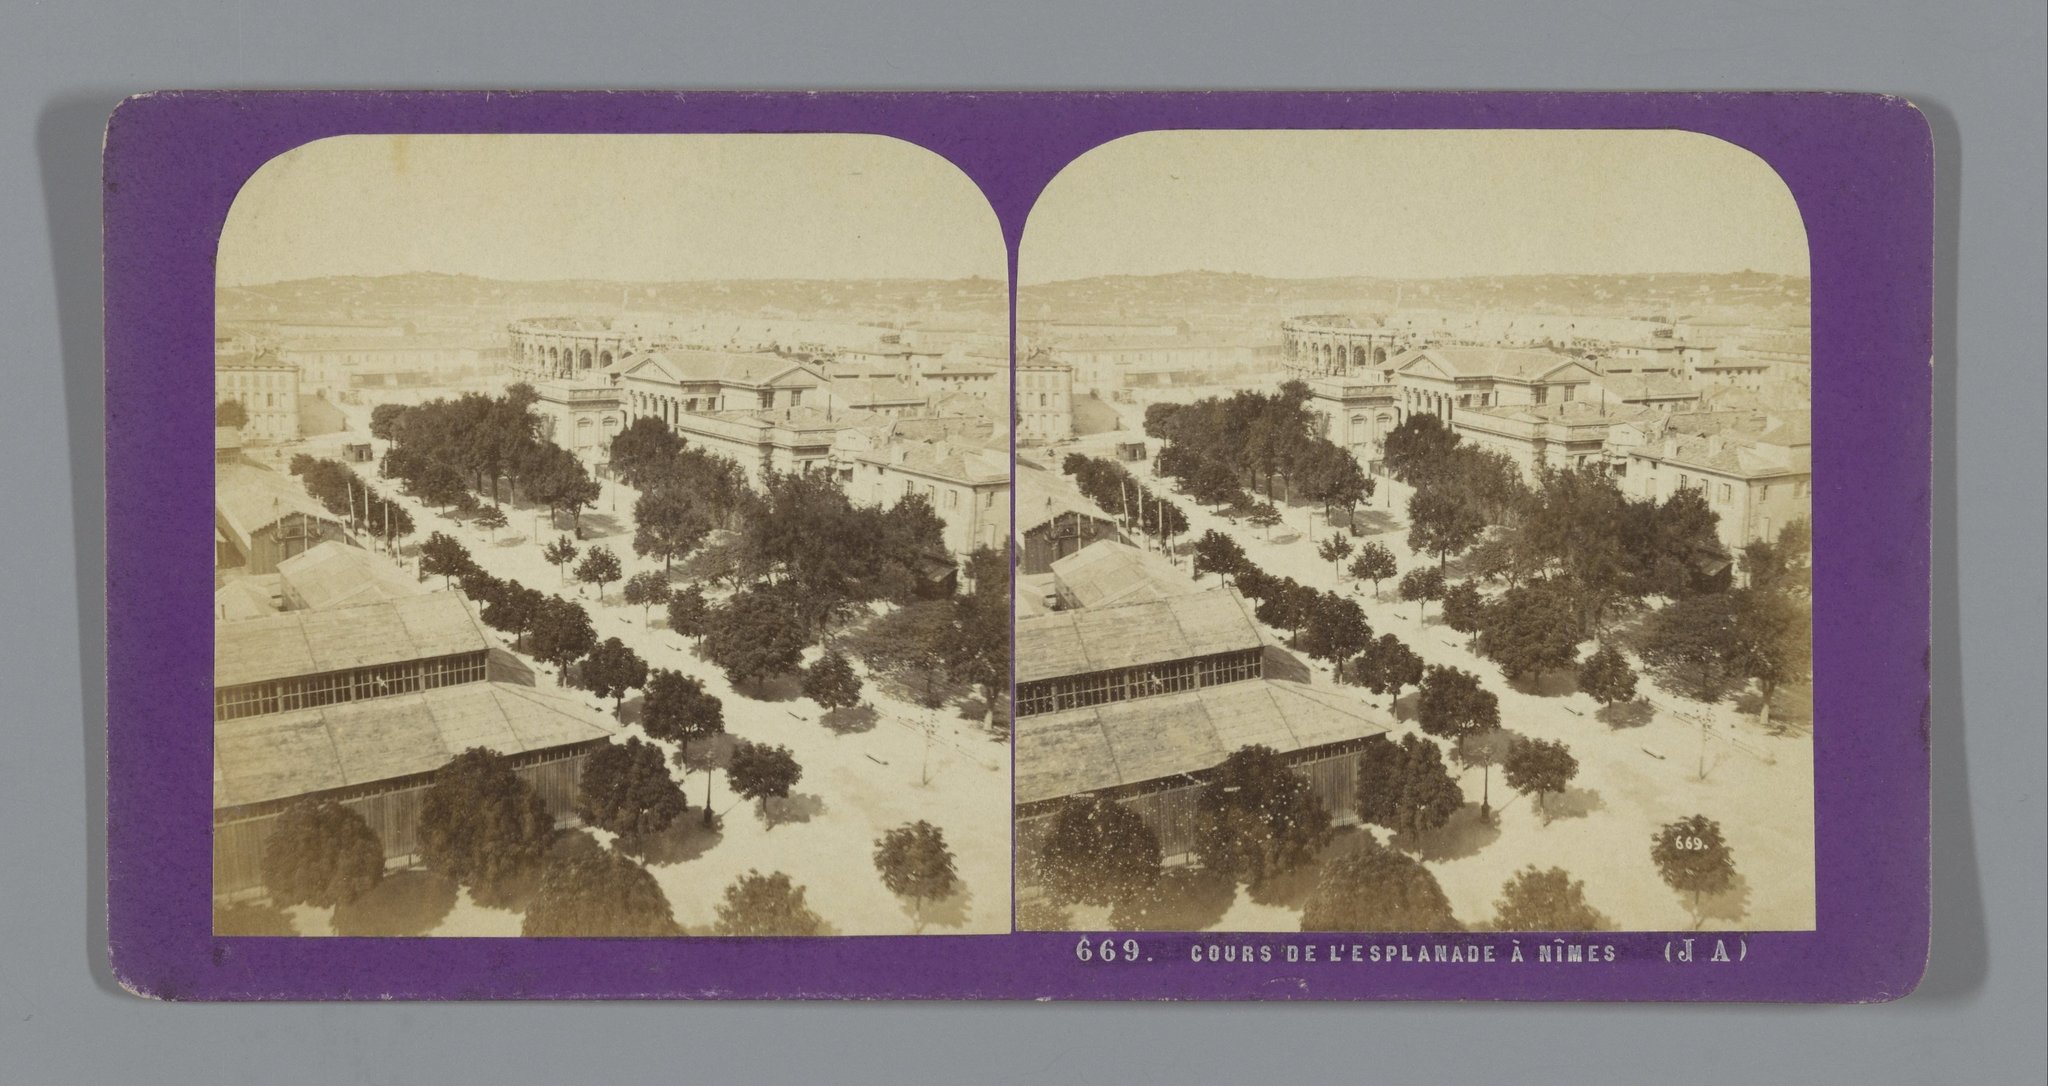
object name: stereograph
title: Gezicht op Nîmes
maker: jean andrieu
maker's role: fotograaf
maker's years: 1816-1872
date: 1862-1876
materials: cardboard, photographic support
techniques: albumen print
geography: nîmes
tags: nîmes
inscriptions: number: ‘669.’